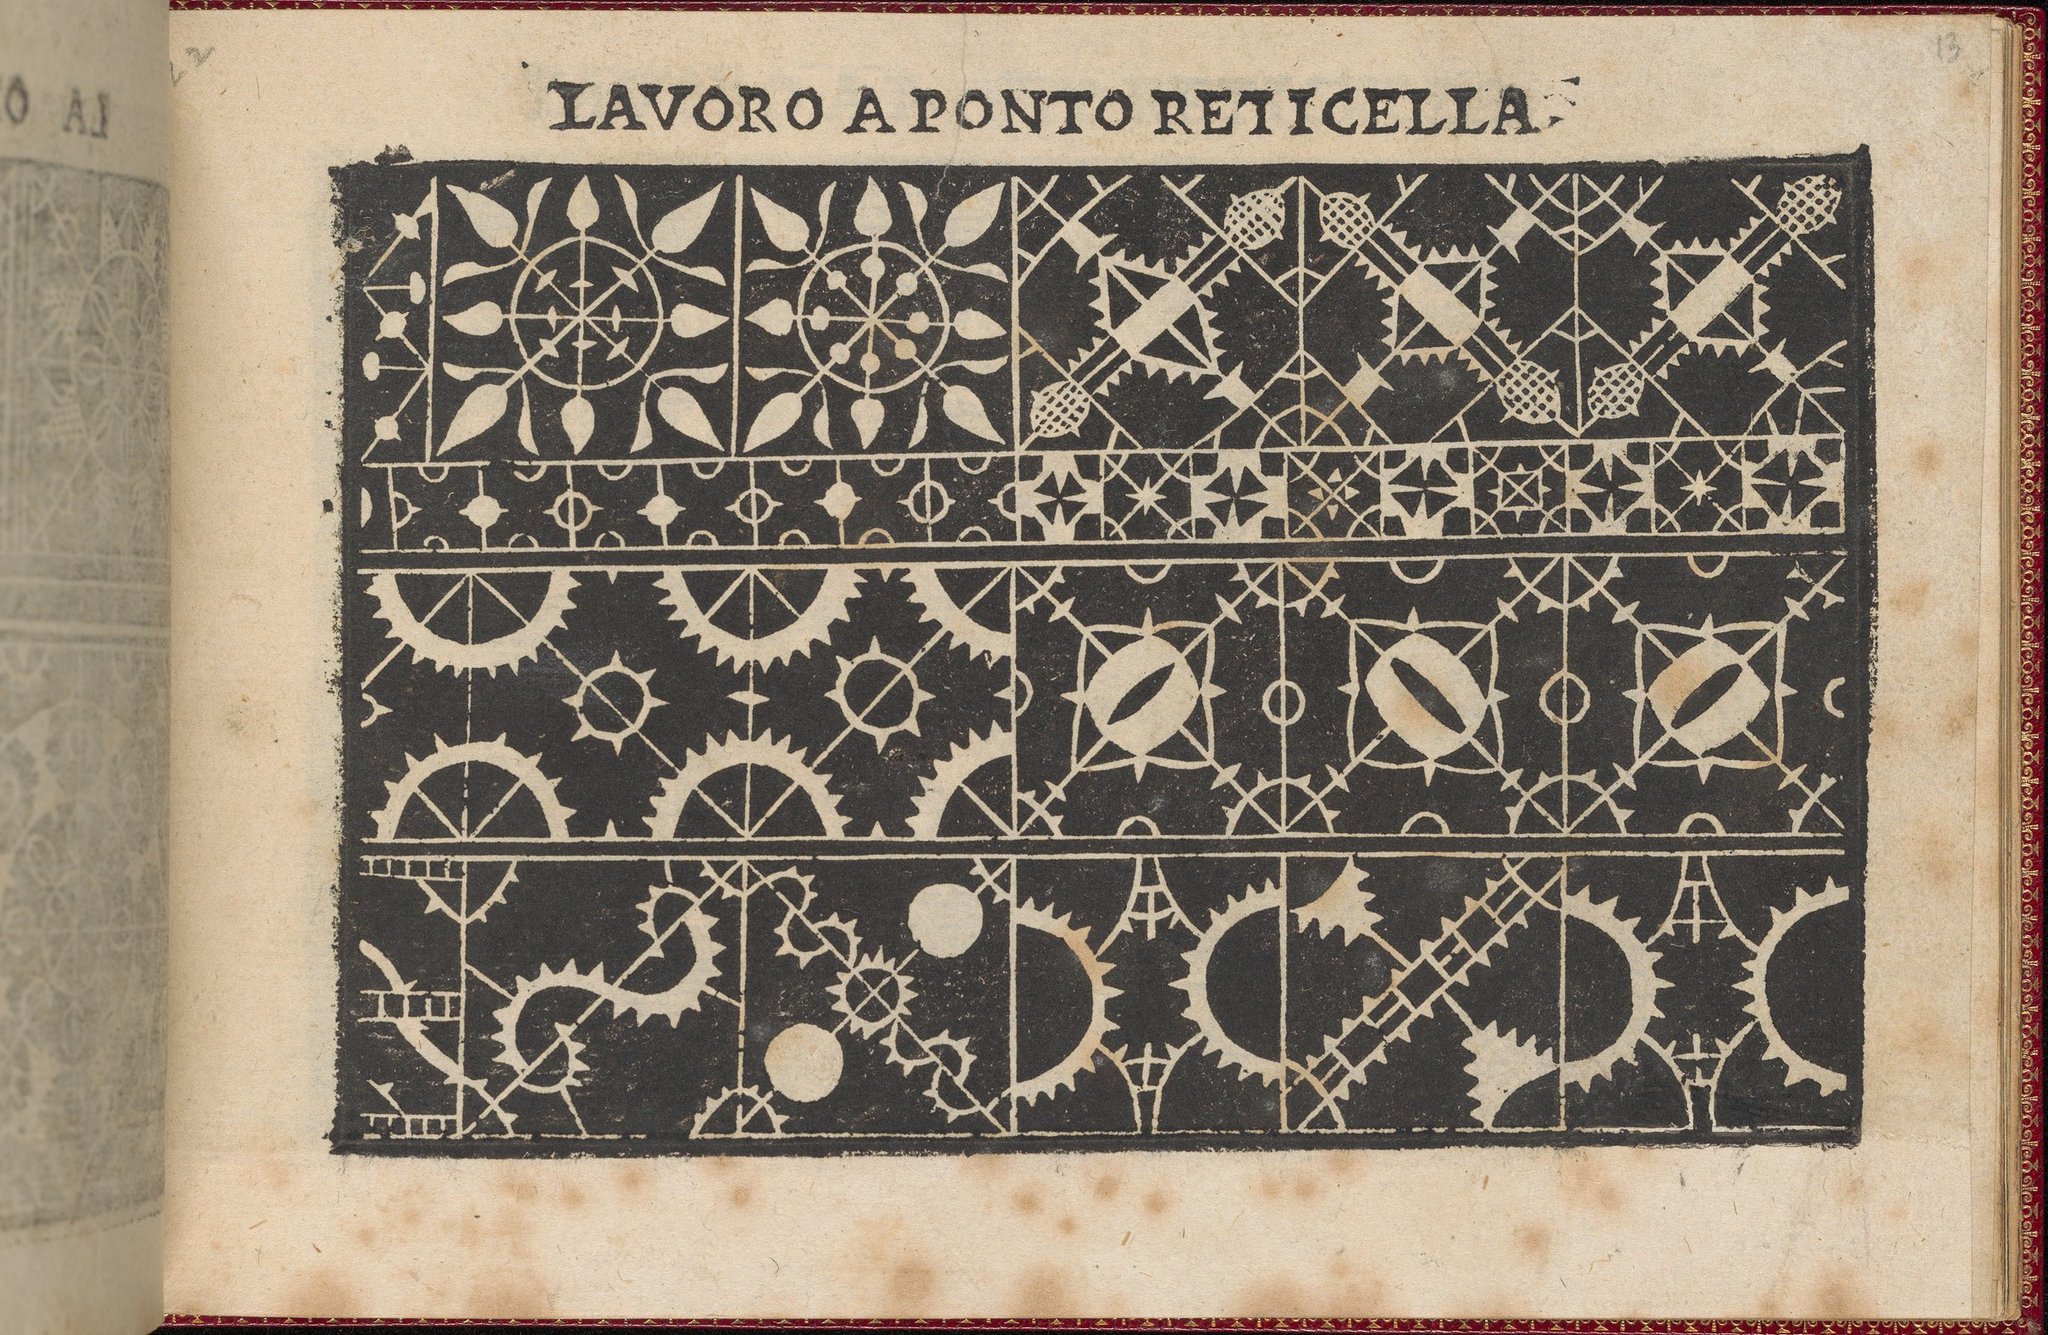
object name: book print ornament architecture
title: Pretiosa Gemma delle virtuose donne, page 15 (recto)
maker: isabella catanea parasole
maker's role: author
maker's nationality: italian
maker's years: 1565-1625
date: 1600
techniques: woodcut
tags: ornament